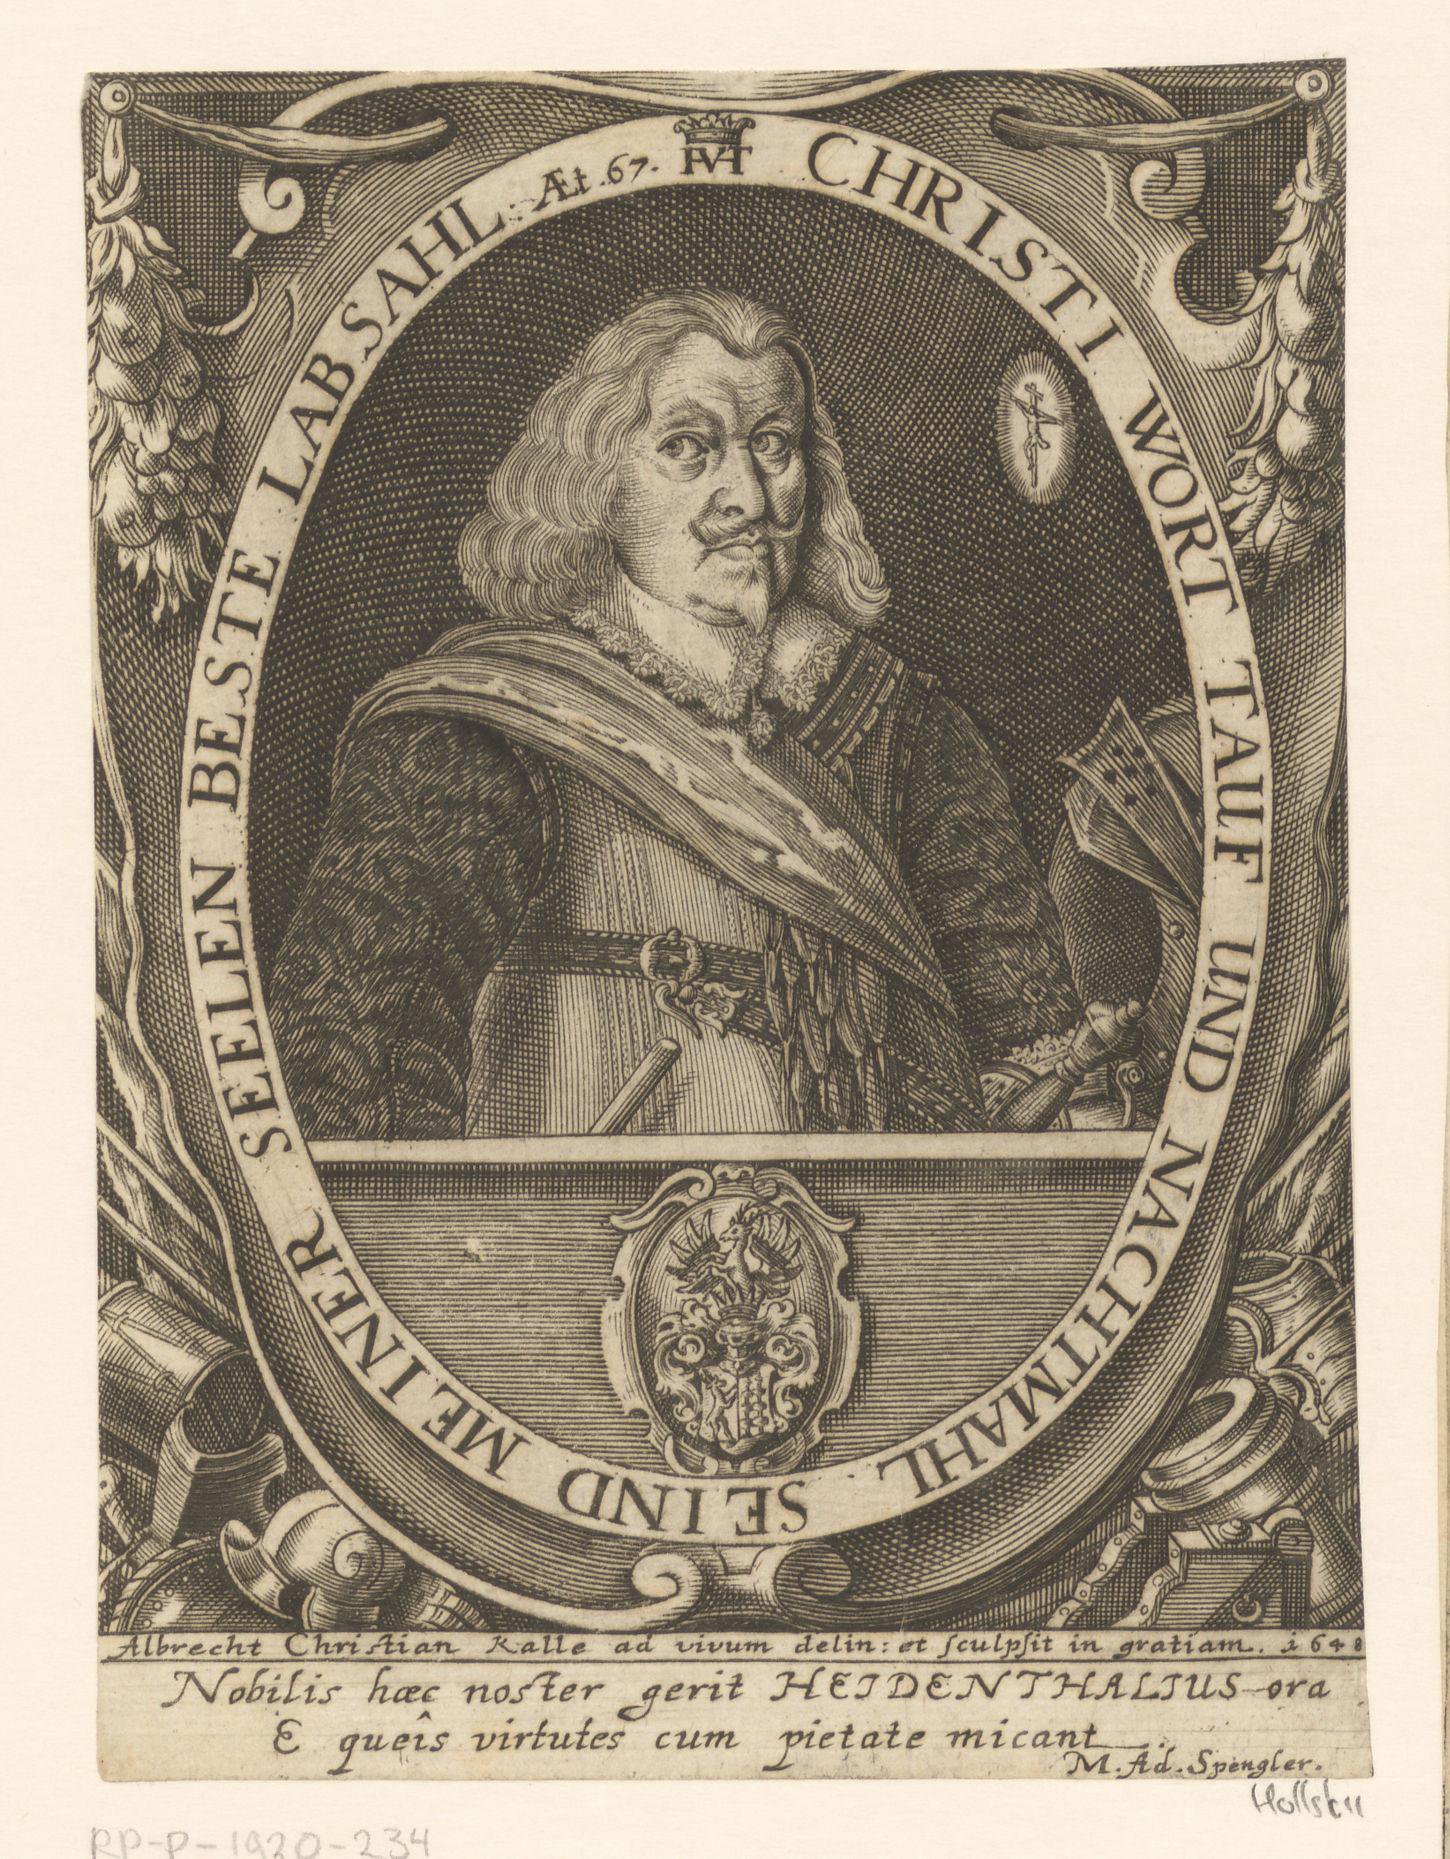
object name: print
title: Portret van generaal Heidenthal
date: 1648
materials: paper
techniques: engraving, etching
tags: historical persons, officer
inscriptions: collector's mark: Lugt 2228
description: Tekst in het Latijn in de omlijsting en in de marge.